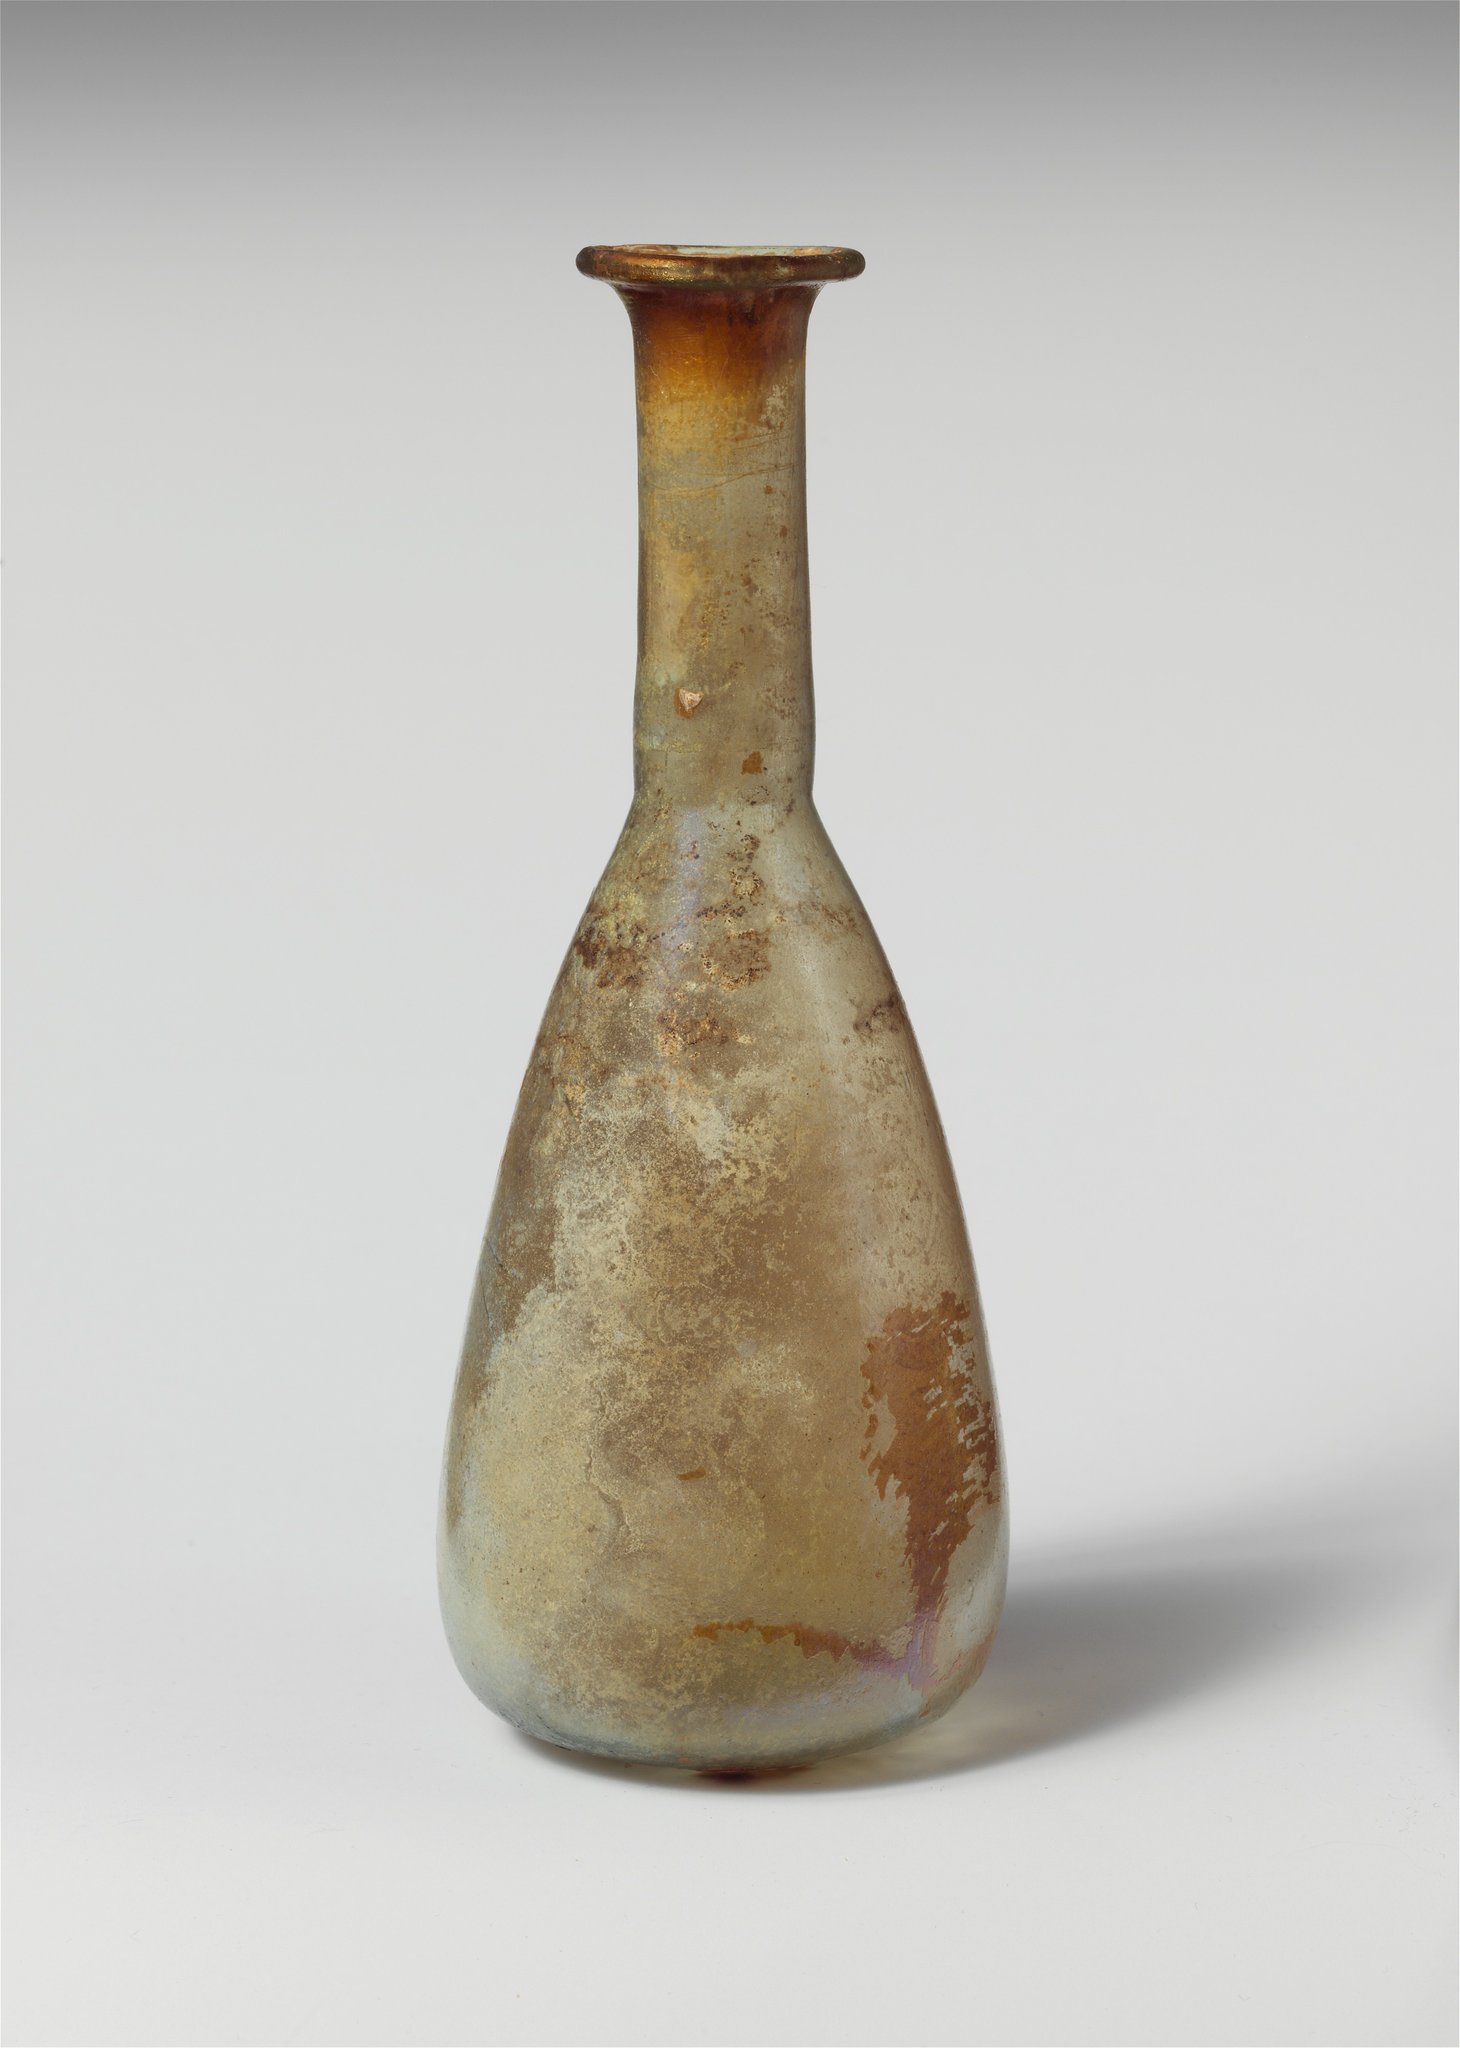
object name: perfume bottle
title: Glass perfume bottle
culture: roman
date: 1-100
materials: glass